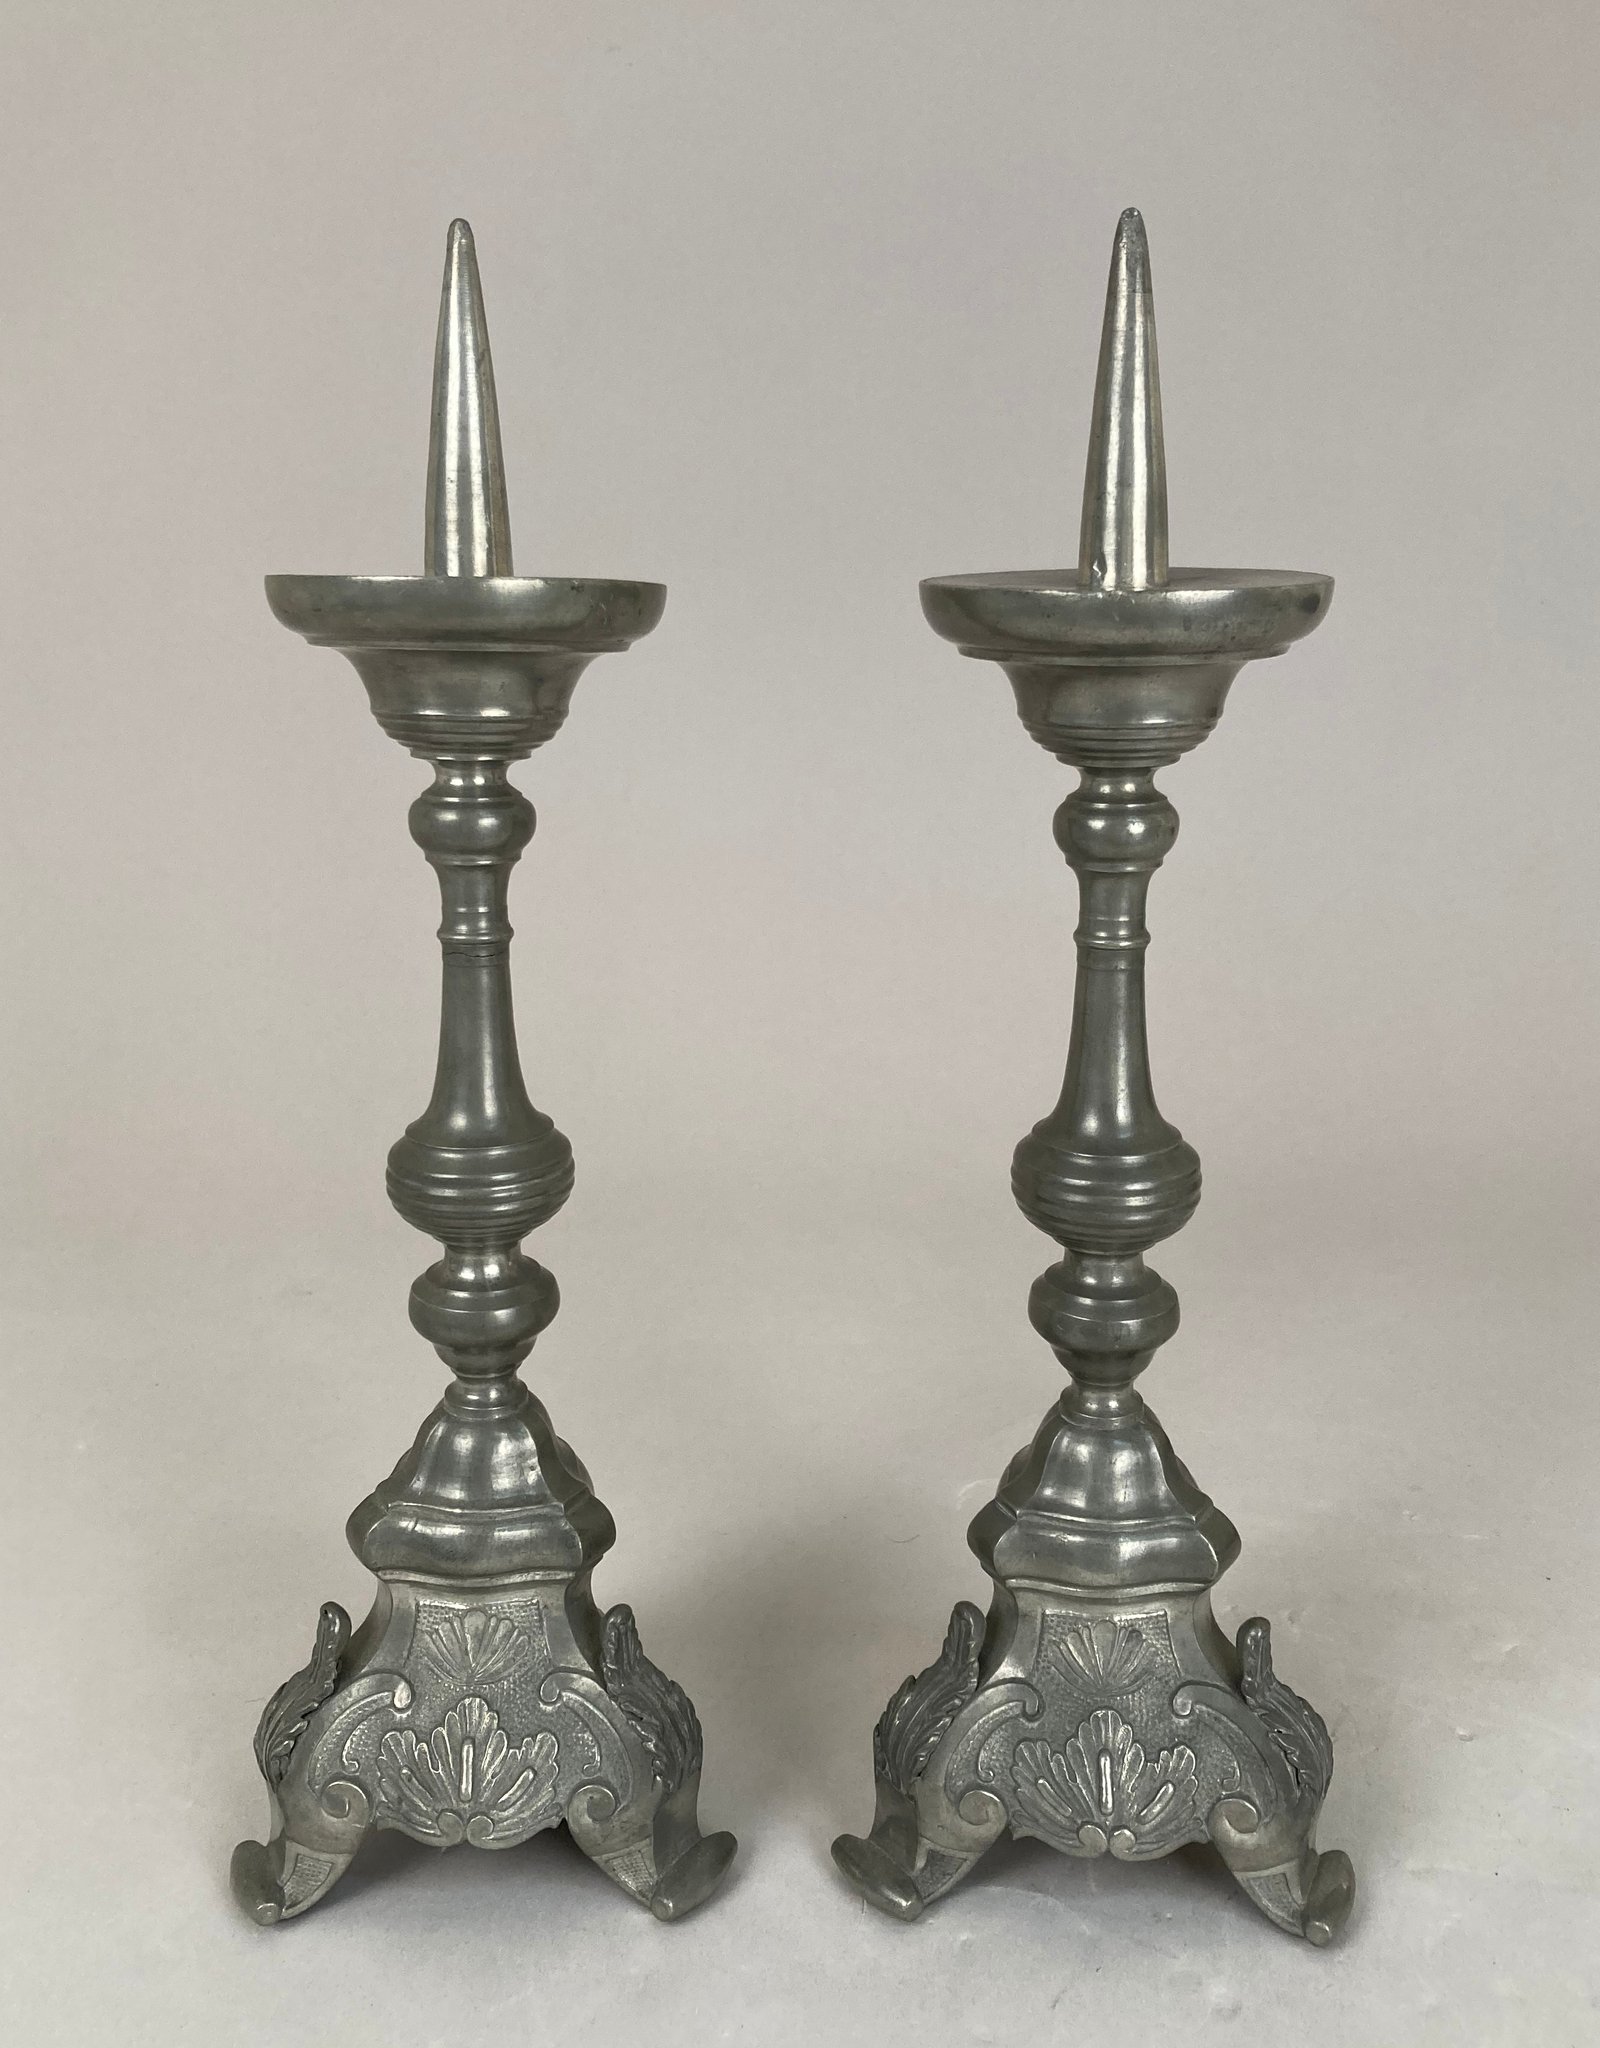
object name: altar candlestick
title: Pair of altar candlesticks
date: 1701-1800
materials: pewter